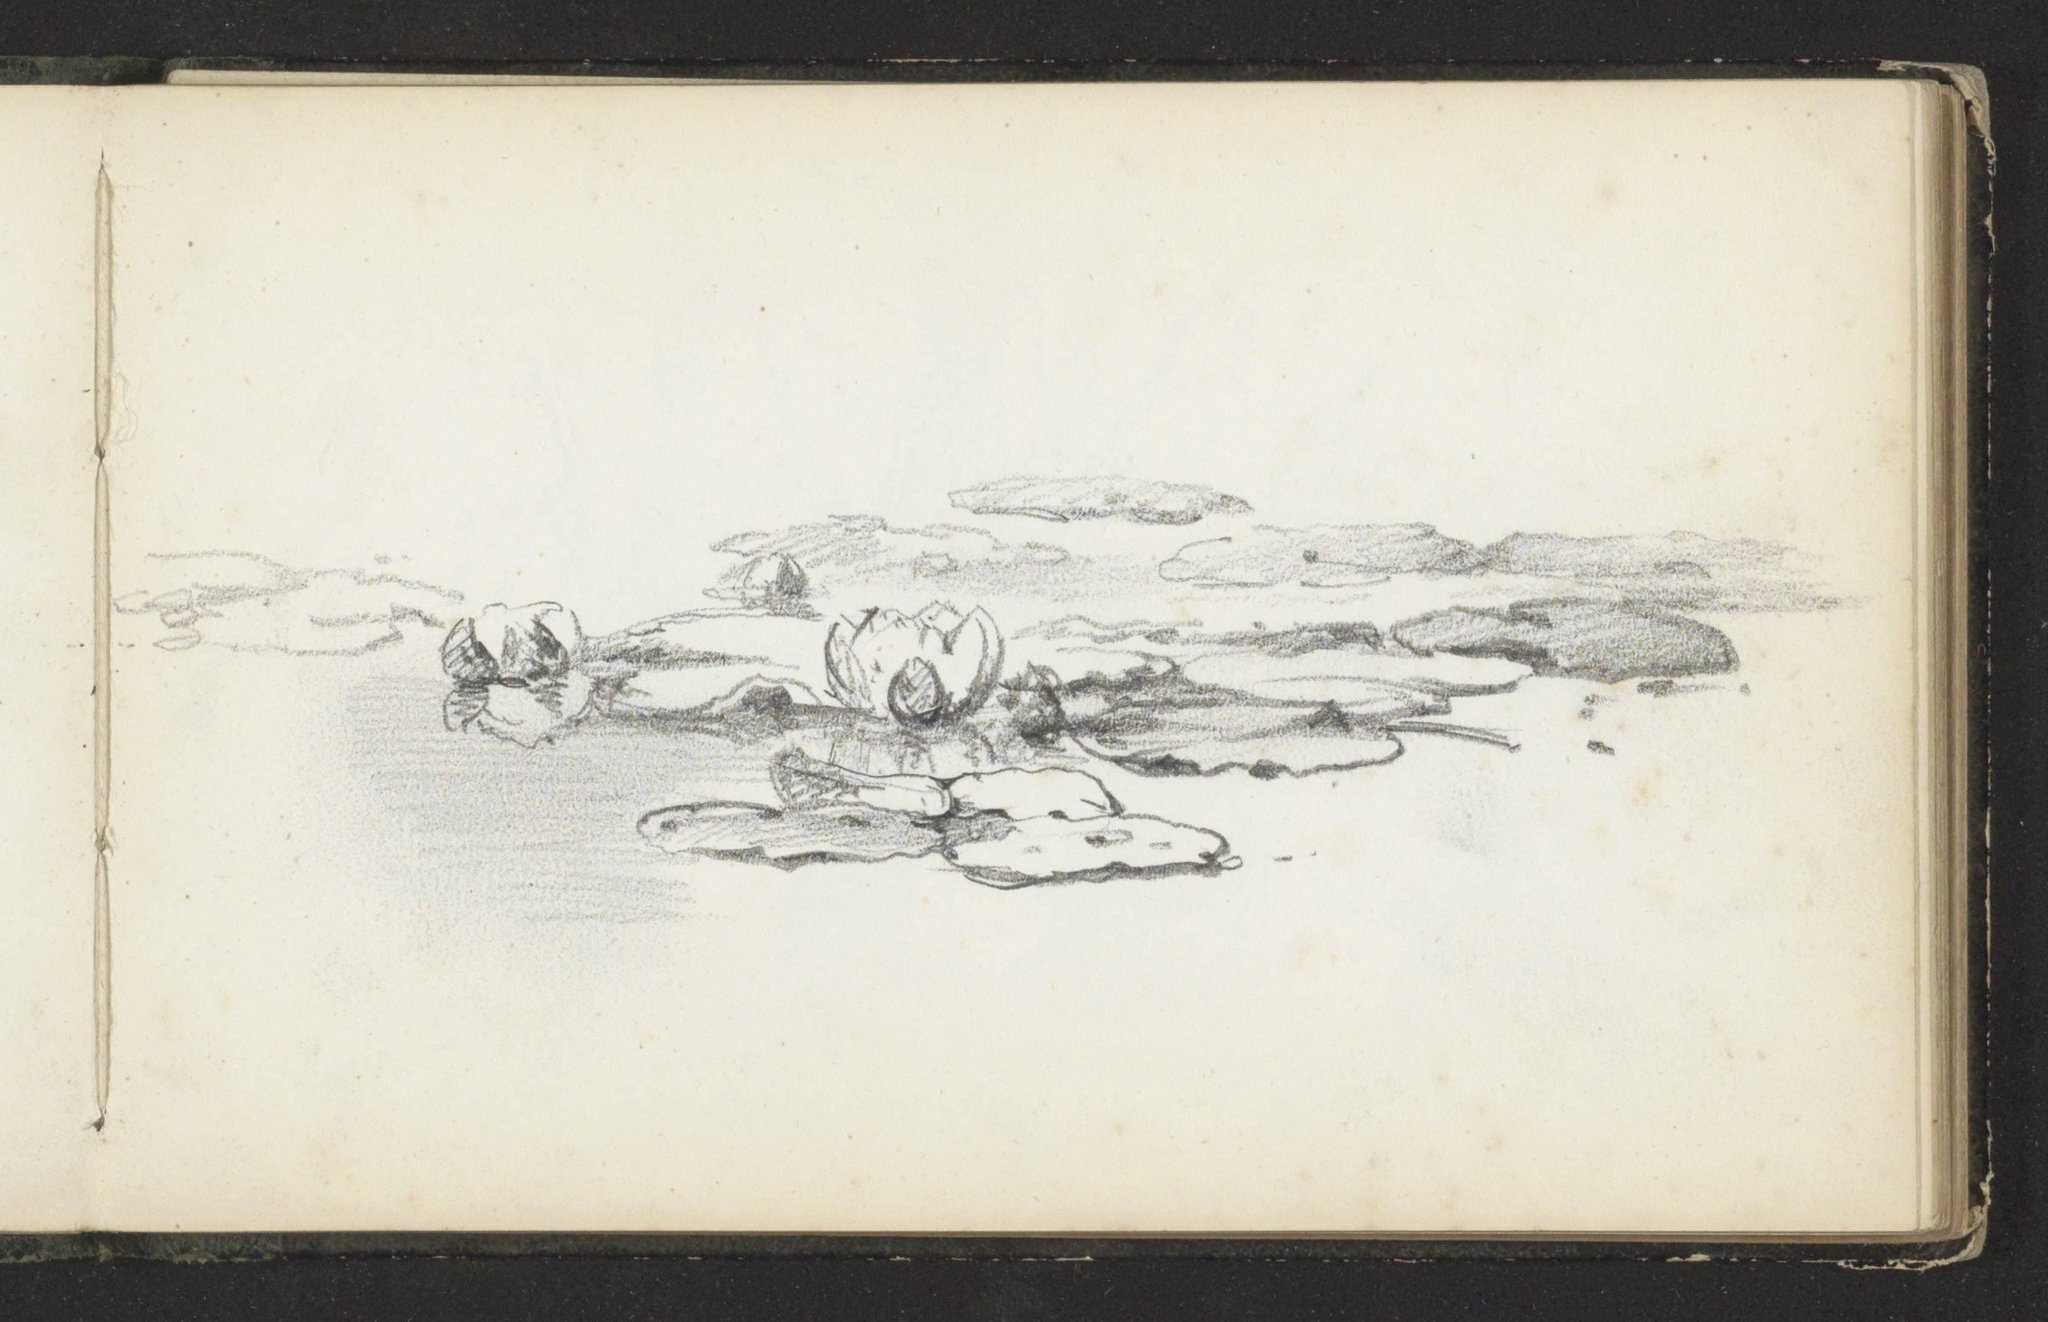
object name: sketchbook leaf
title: Waterlelies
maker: maria vos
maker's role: draughtsman, painter, print maker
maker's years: 1824-1906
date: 1856-1870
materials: paper, pencil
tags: flowers: water-lily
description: Blad 9 recto uit een schetsboek met 39 bladen.